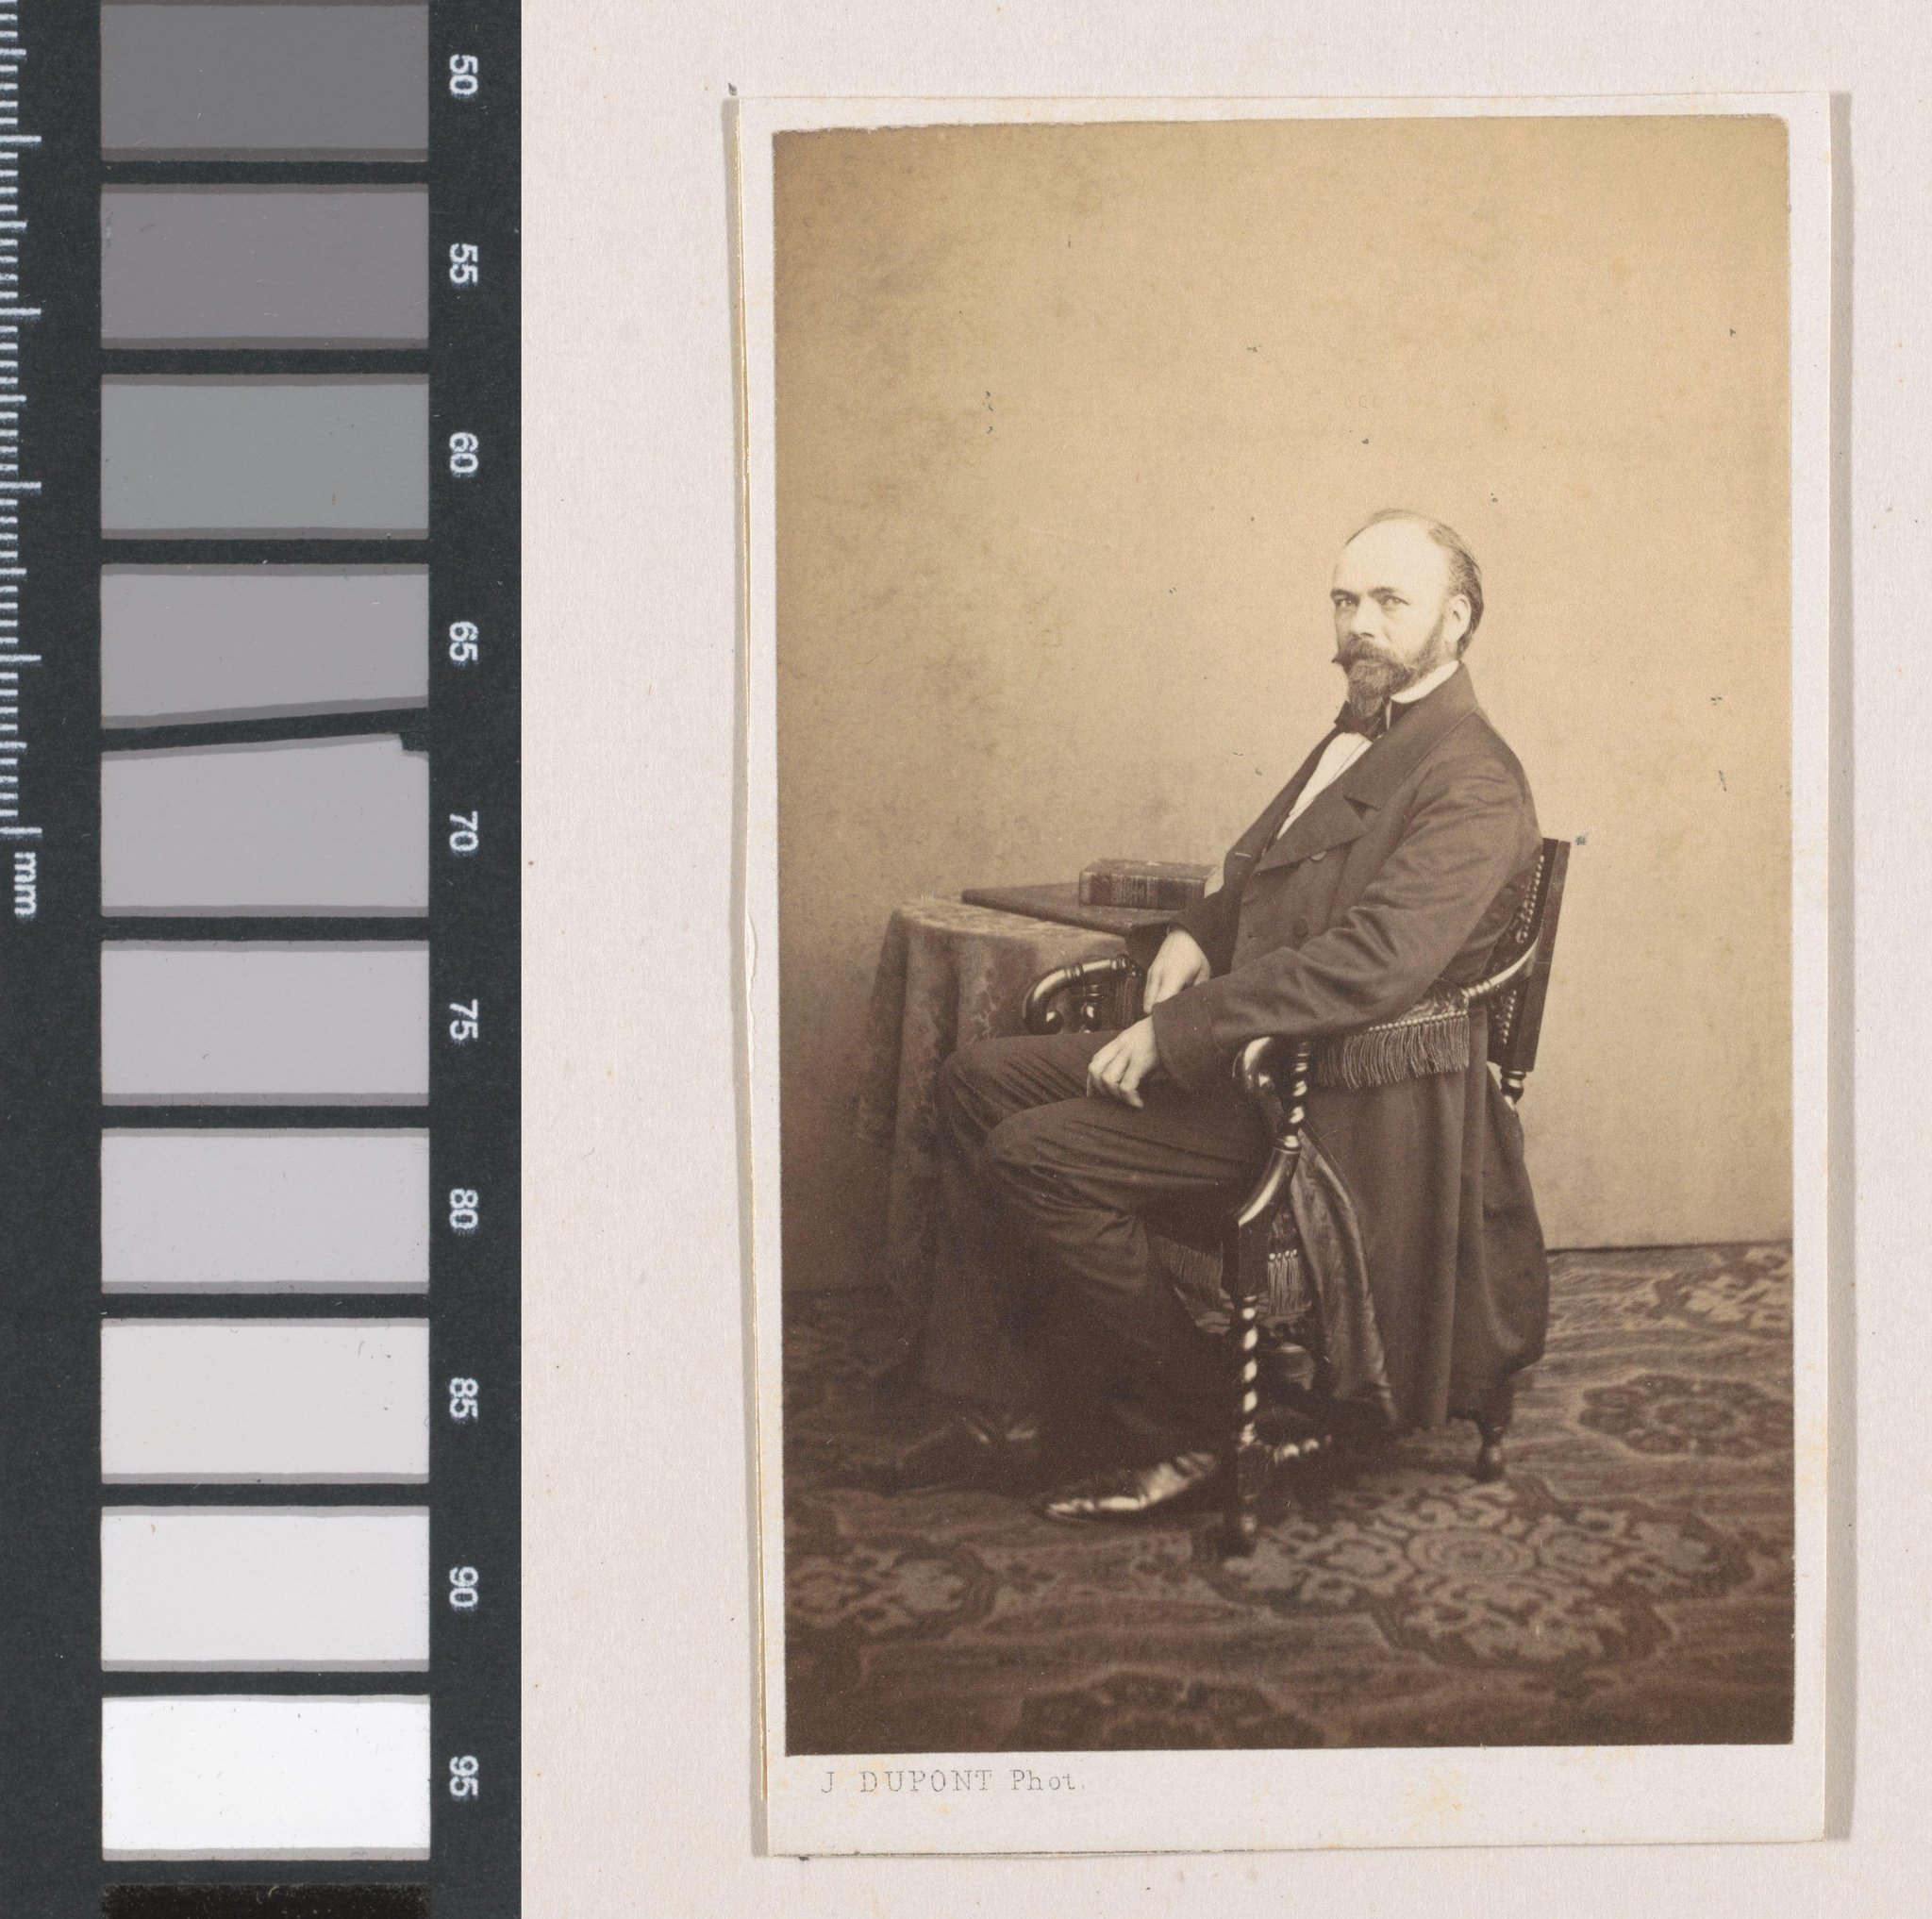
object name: photograph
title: Portret van de schilder Jean Louis Van Kuyck, ten voeten uit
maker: joseph dupont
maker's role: fotograaf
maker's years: 1818-1901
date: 1861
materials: cardboard, paper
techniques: albumen print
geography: antwerp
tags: print maker, jean louis van kuyck, historical persons, portrait, self-portrait of painter, portrait, self-portrait of artist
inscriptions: inscription: ‘ETABLISSEMENT PHOTOGRAPHIQUE/ de/ J. DUPONT/ Place de Meir 32/ ANVERS/ Maison fondée en 1853’